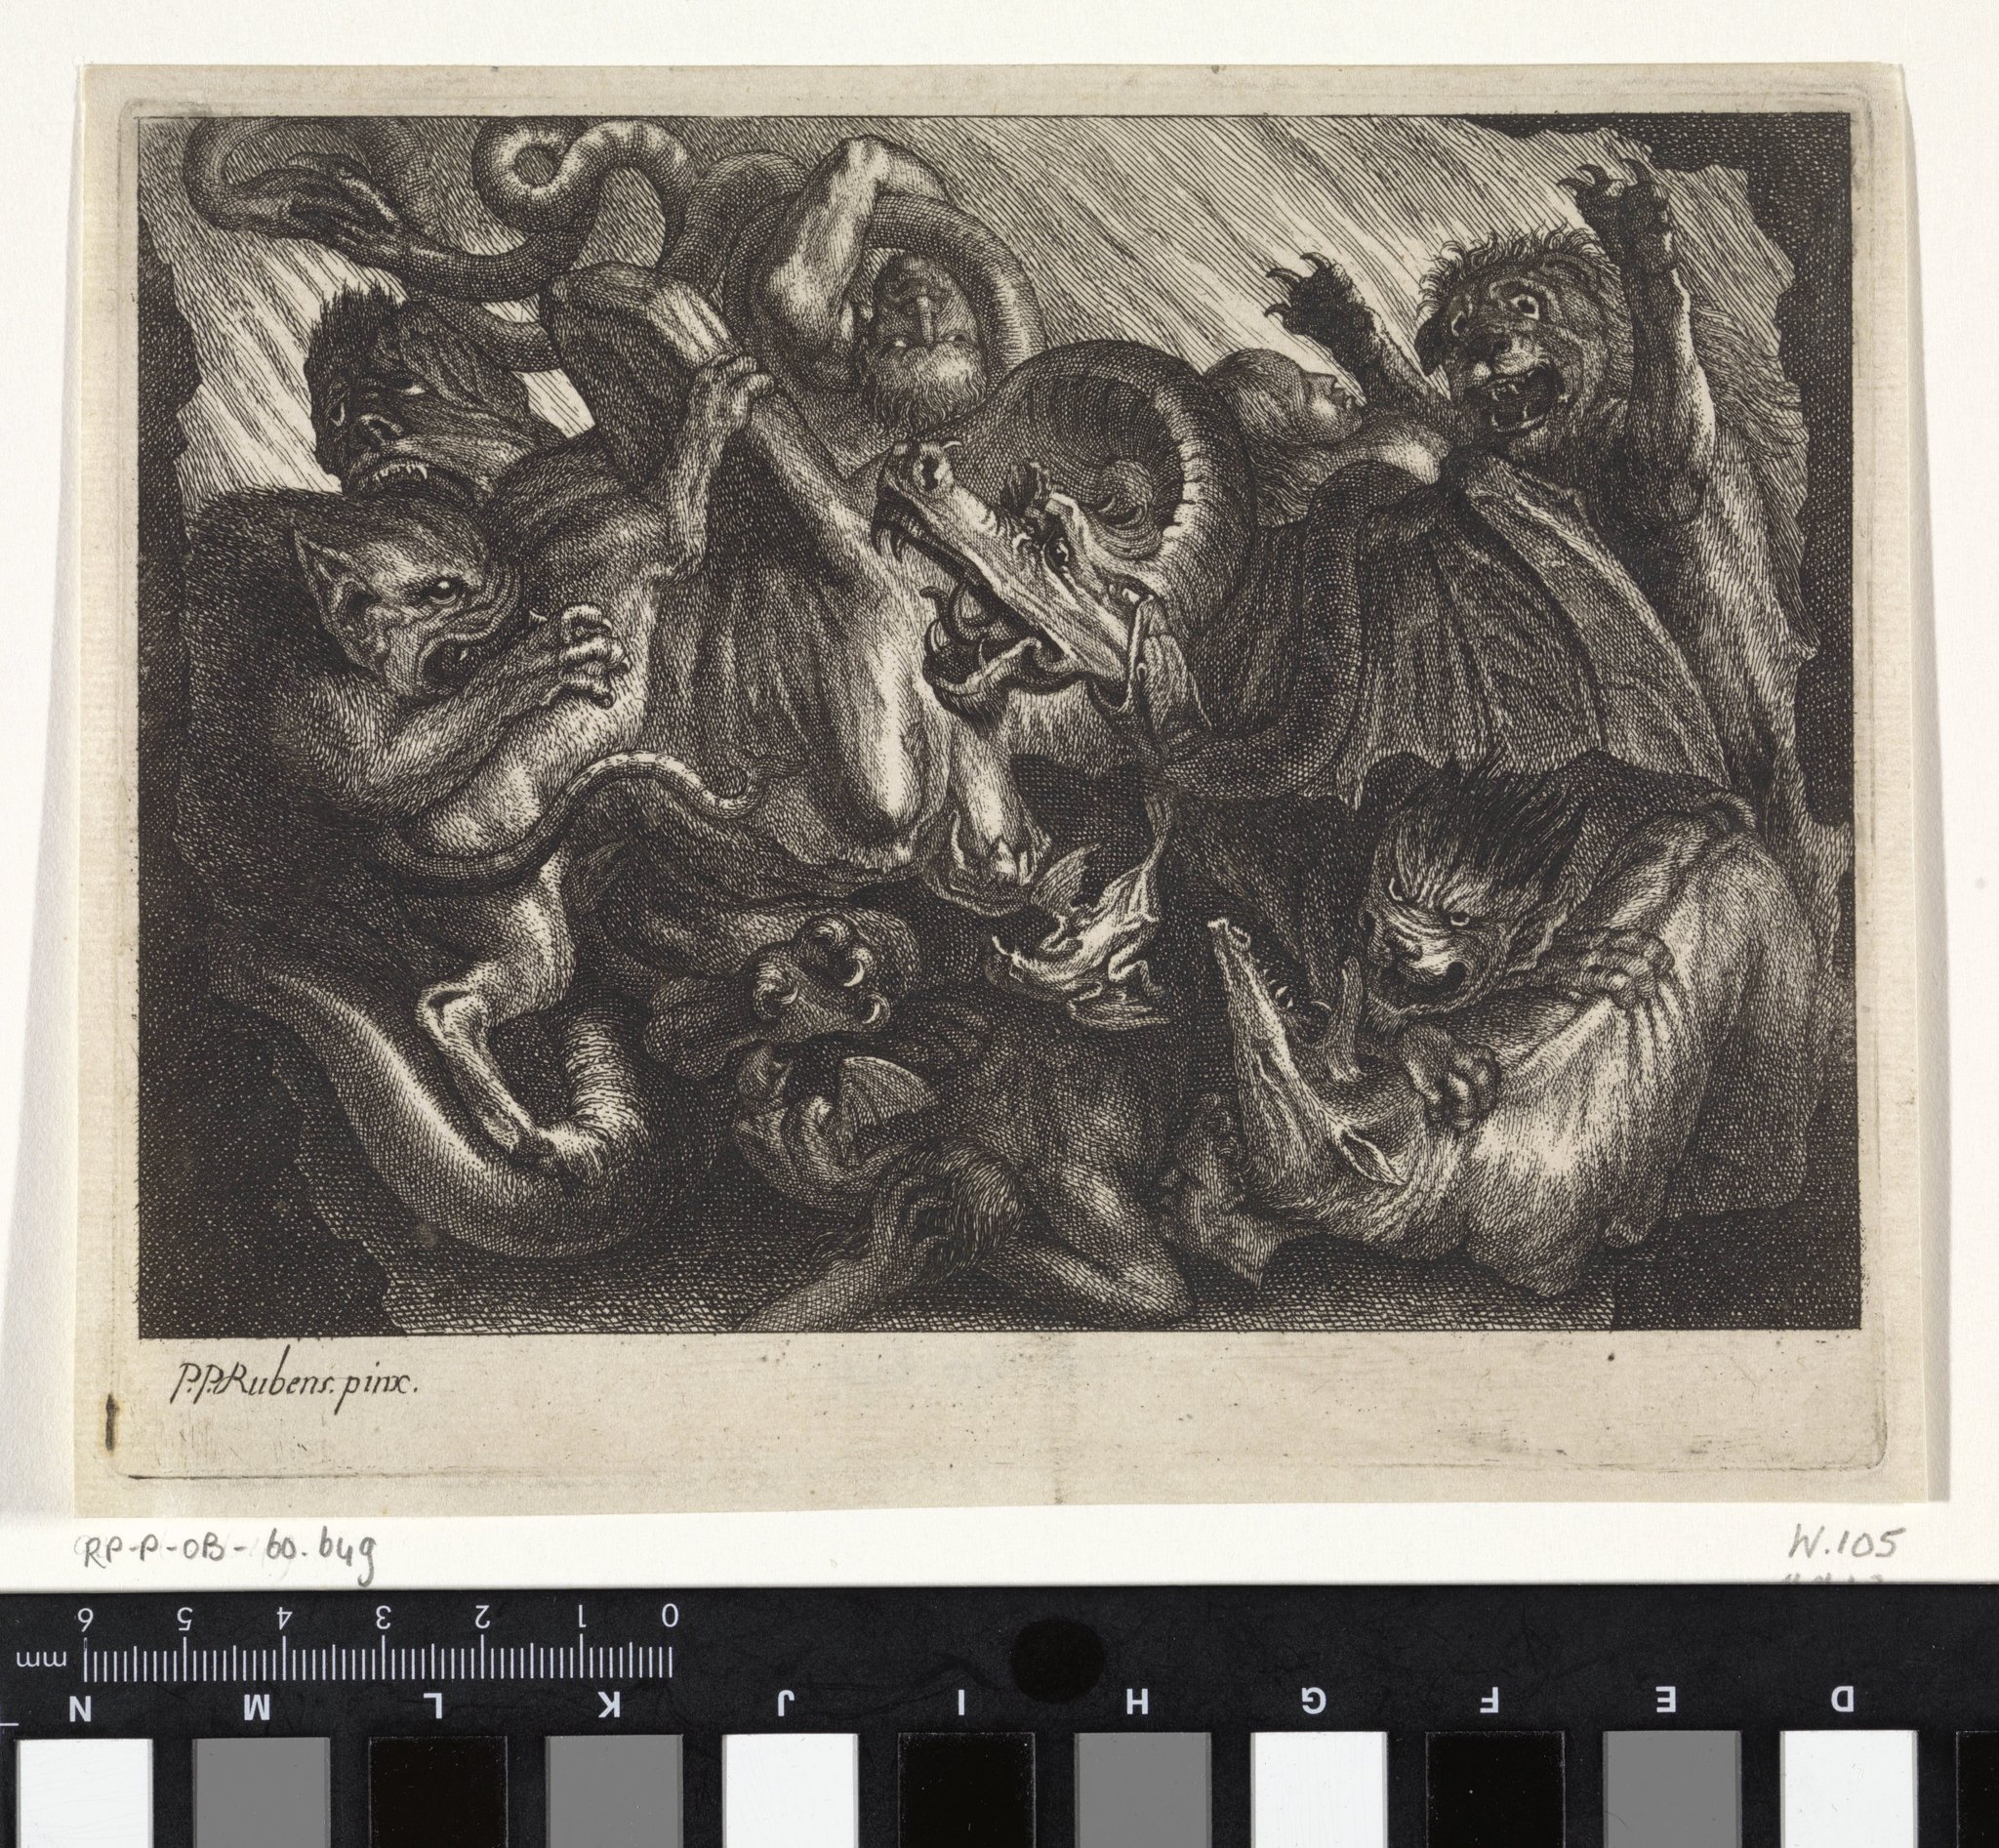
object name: print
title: Hel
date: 1623-1686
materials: paper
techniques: engraving, etching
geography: haarlem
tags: devils in the form of (fabulous) animals, devil(s) and demons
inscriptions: collector's mark: Lugt 240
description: Duivels en demonen buitelen over elkaar heen. In het midden een draak en rechts een leeuw.